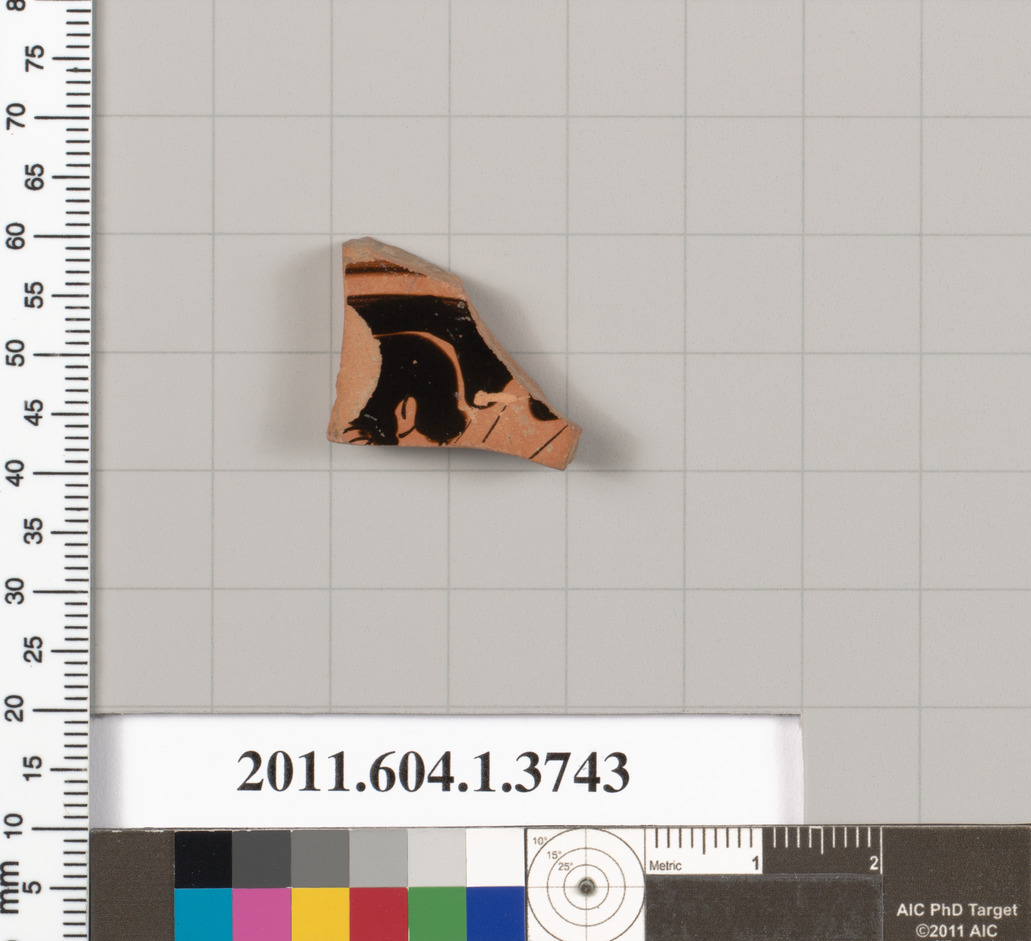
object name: kylix fragment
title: Terracotta fragment of a kylix (drinking cup)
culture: greek, attic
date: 475-451 BCE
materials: terracotta